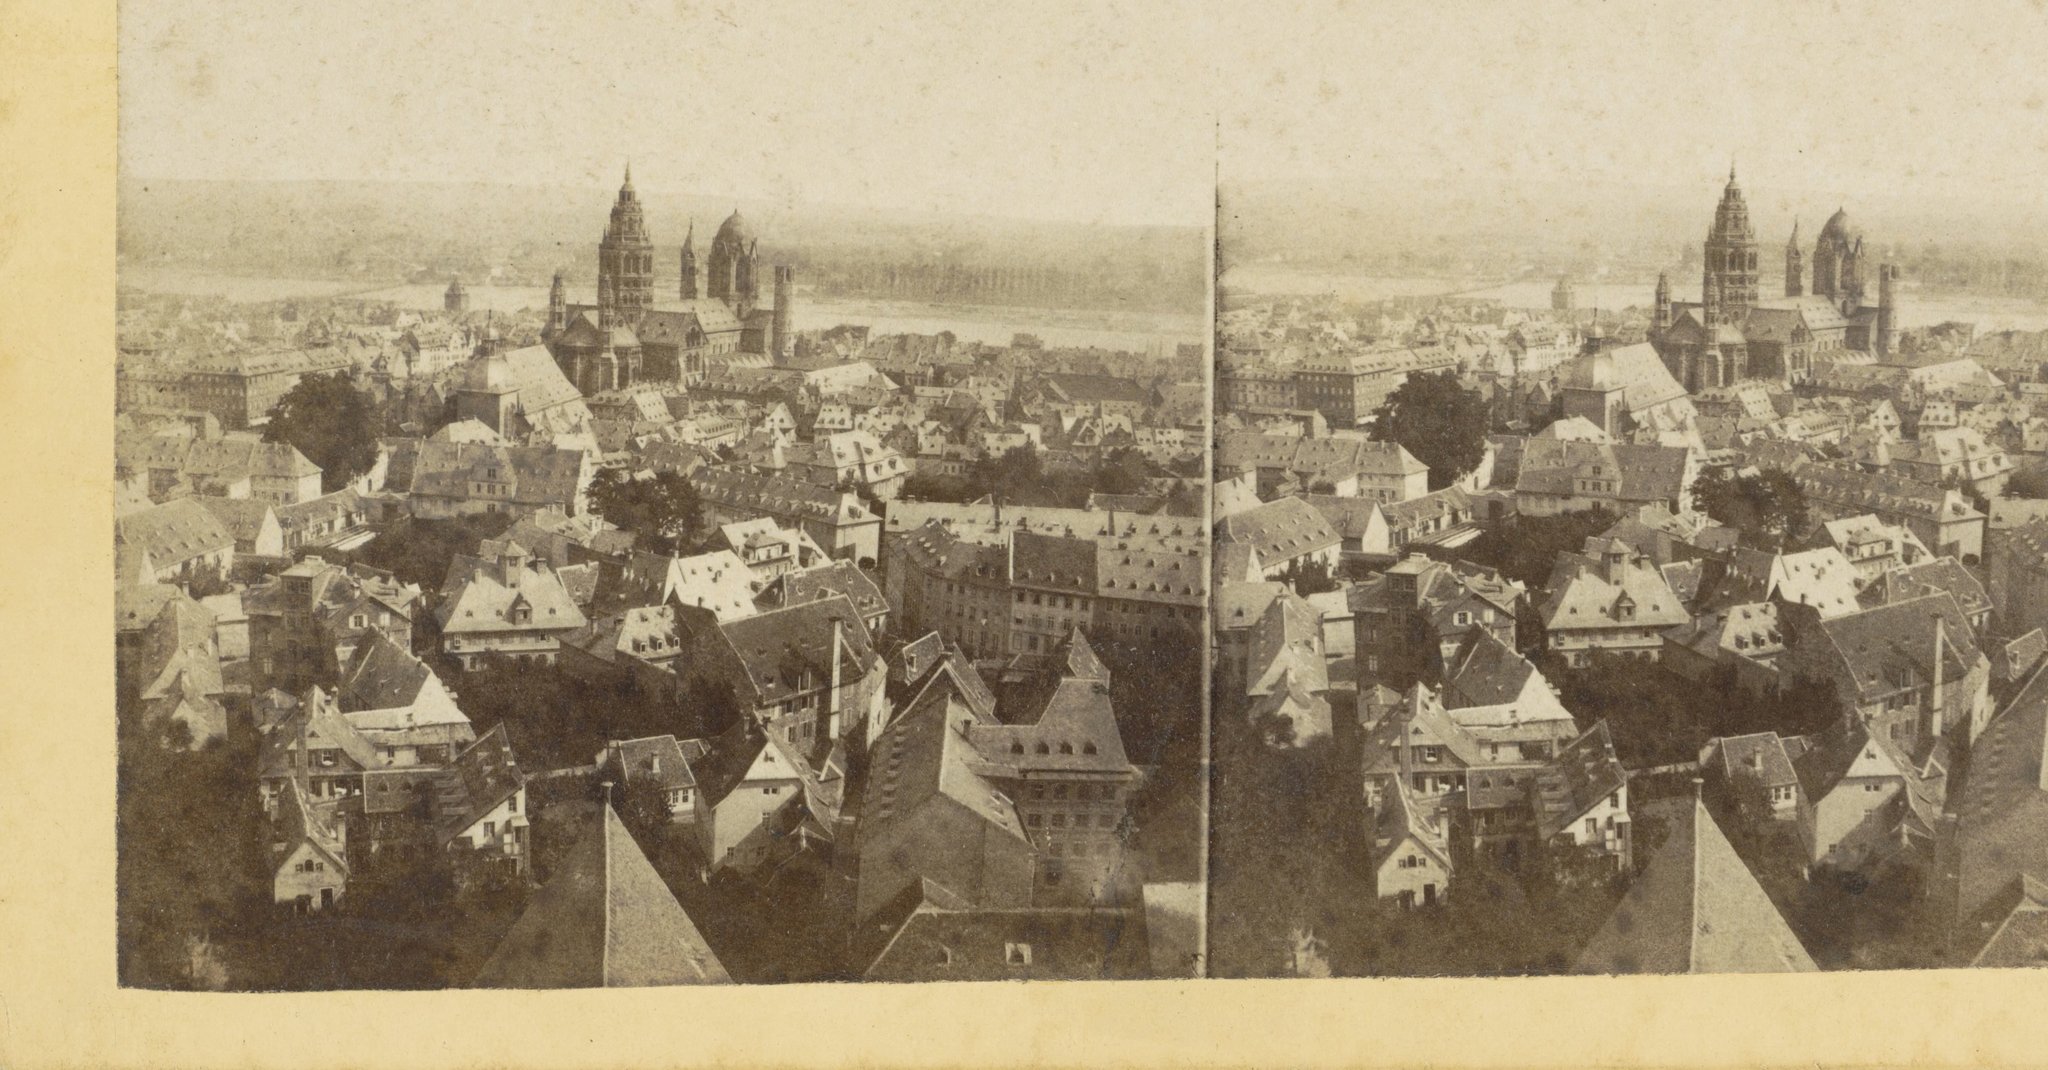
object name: stereograph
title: Panorama de Mayence pris à St.Stephane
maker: Anonymous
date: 1861-1870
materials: cardboard, paper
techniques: albumen print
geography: mainz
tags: city-view in general; 'veduta', church (exterior)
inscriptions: number: ‘No 198.’